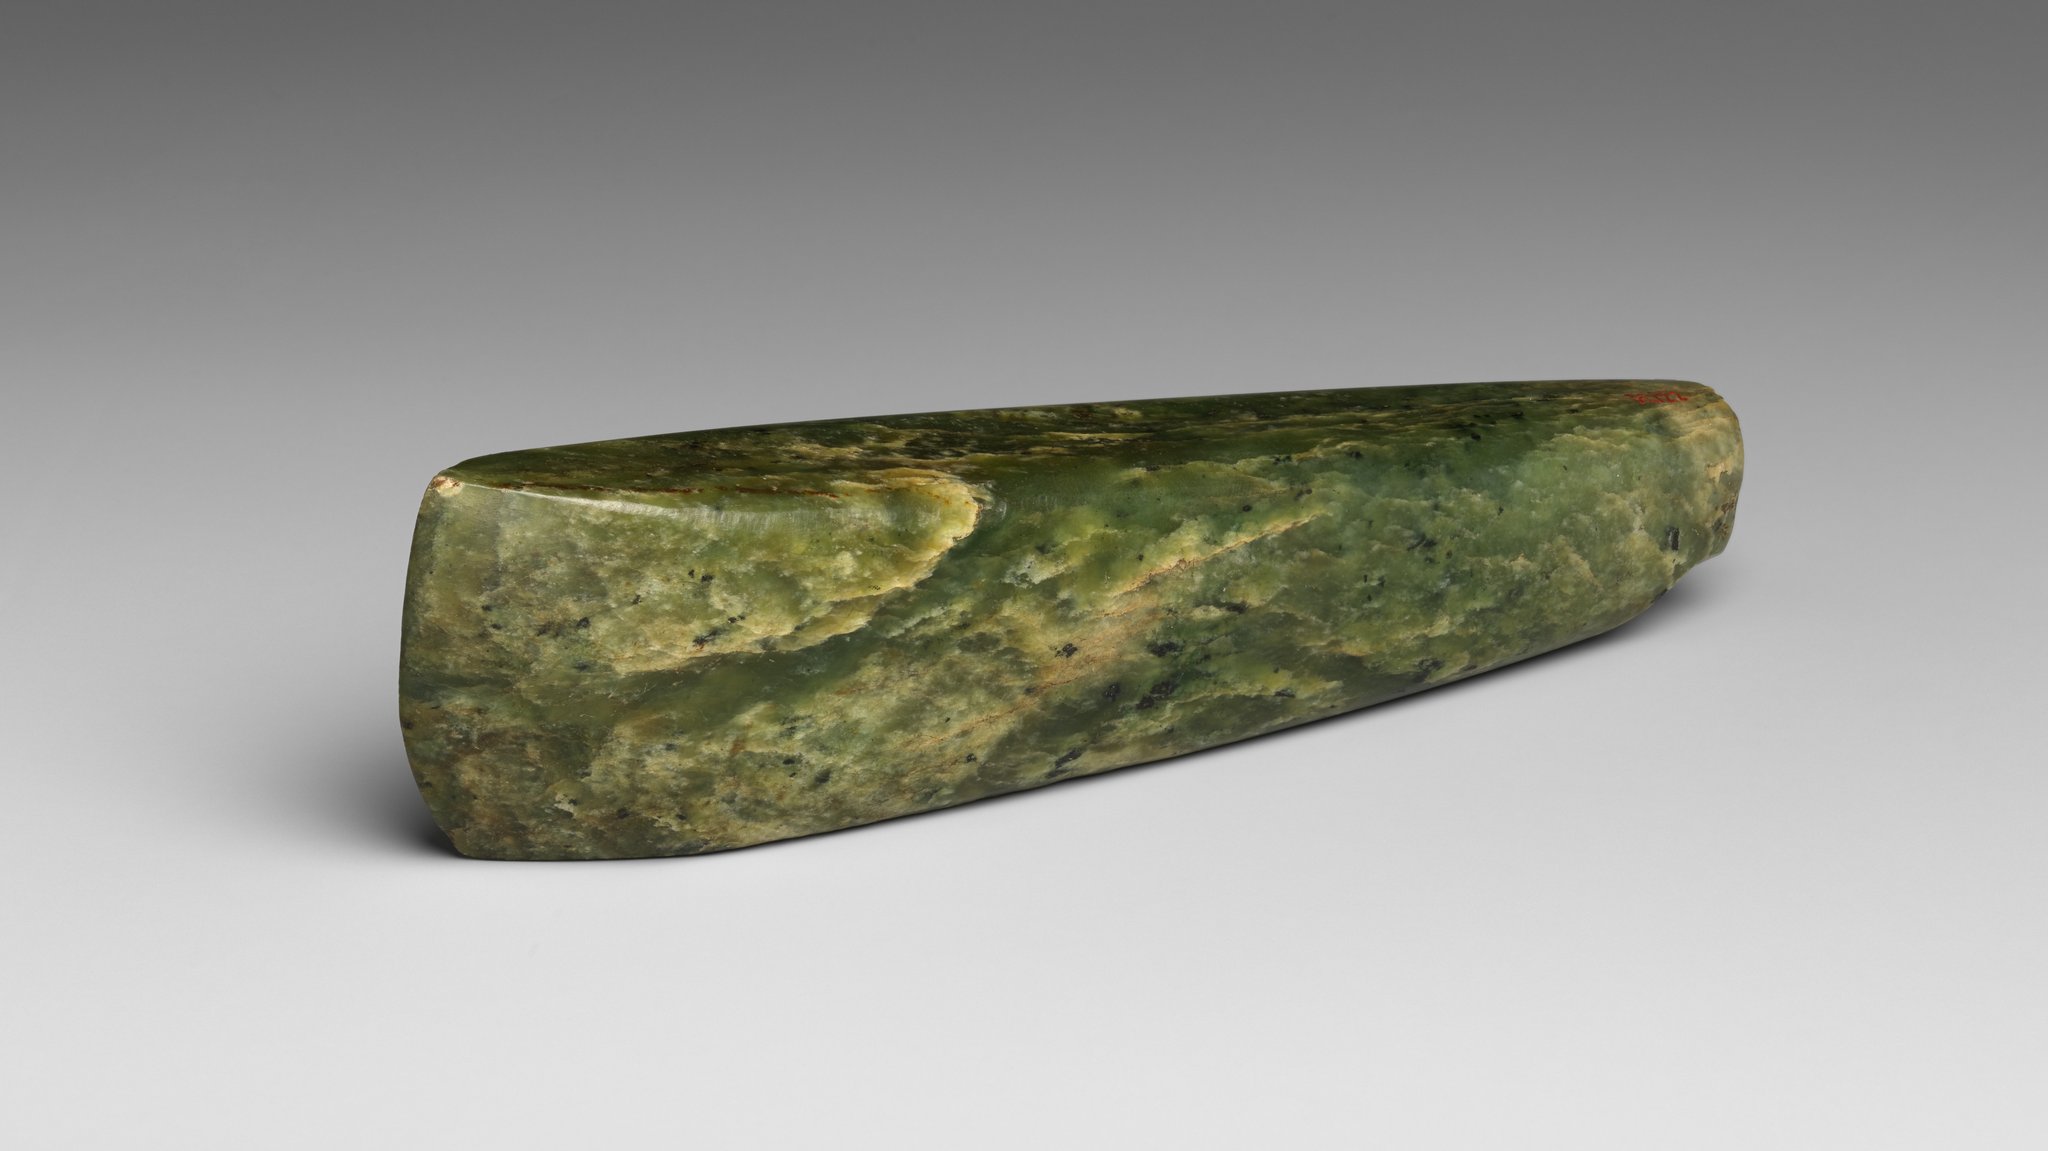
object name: axehead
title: Serpentine axehead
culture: anatolian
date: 2000-1600 BCE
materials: stone